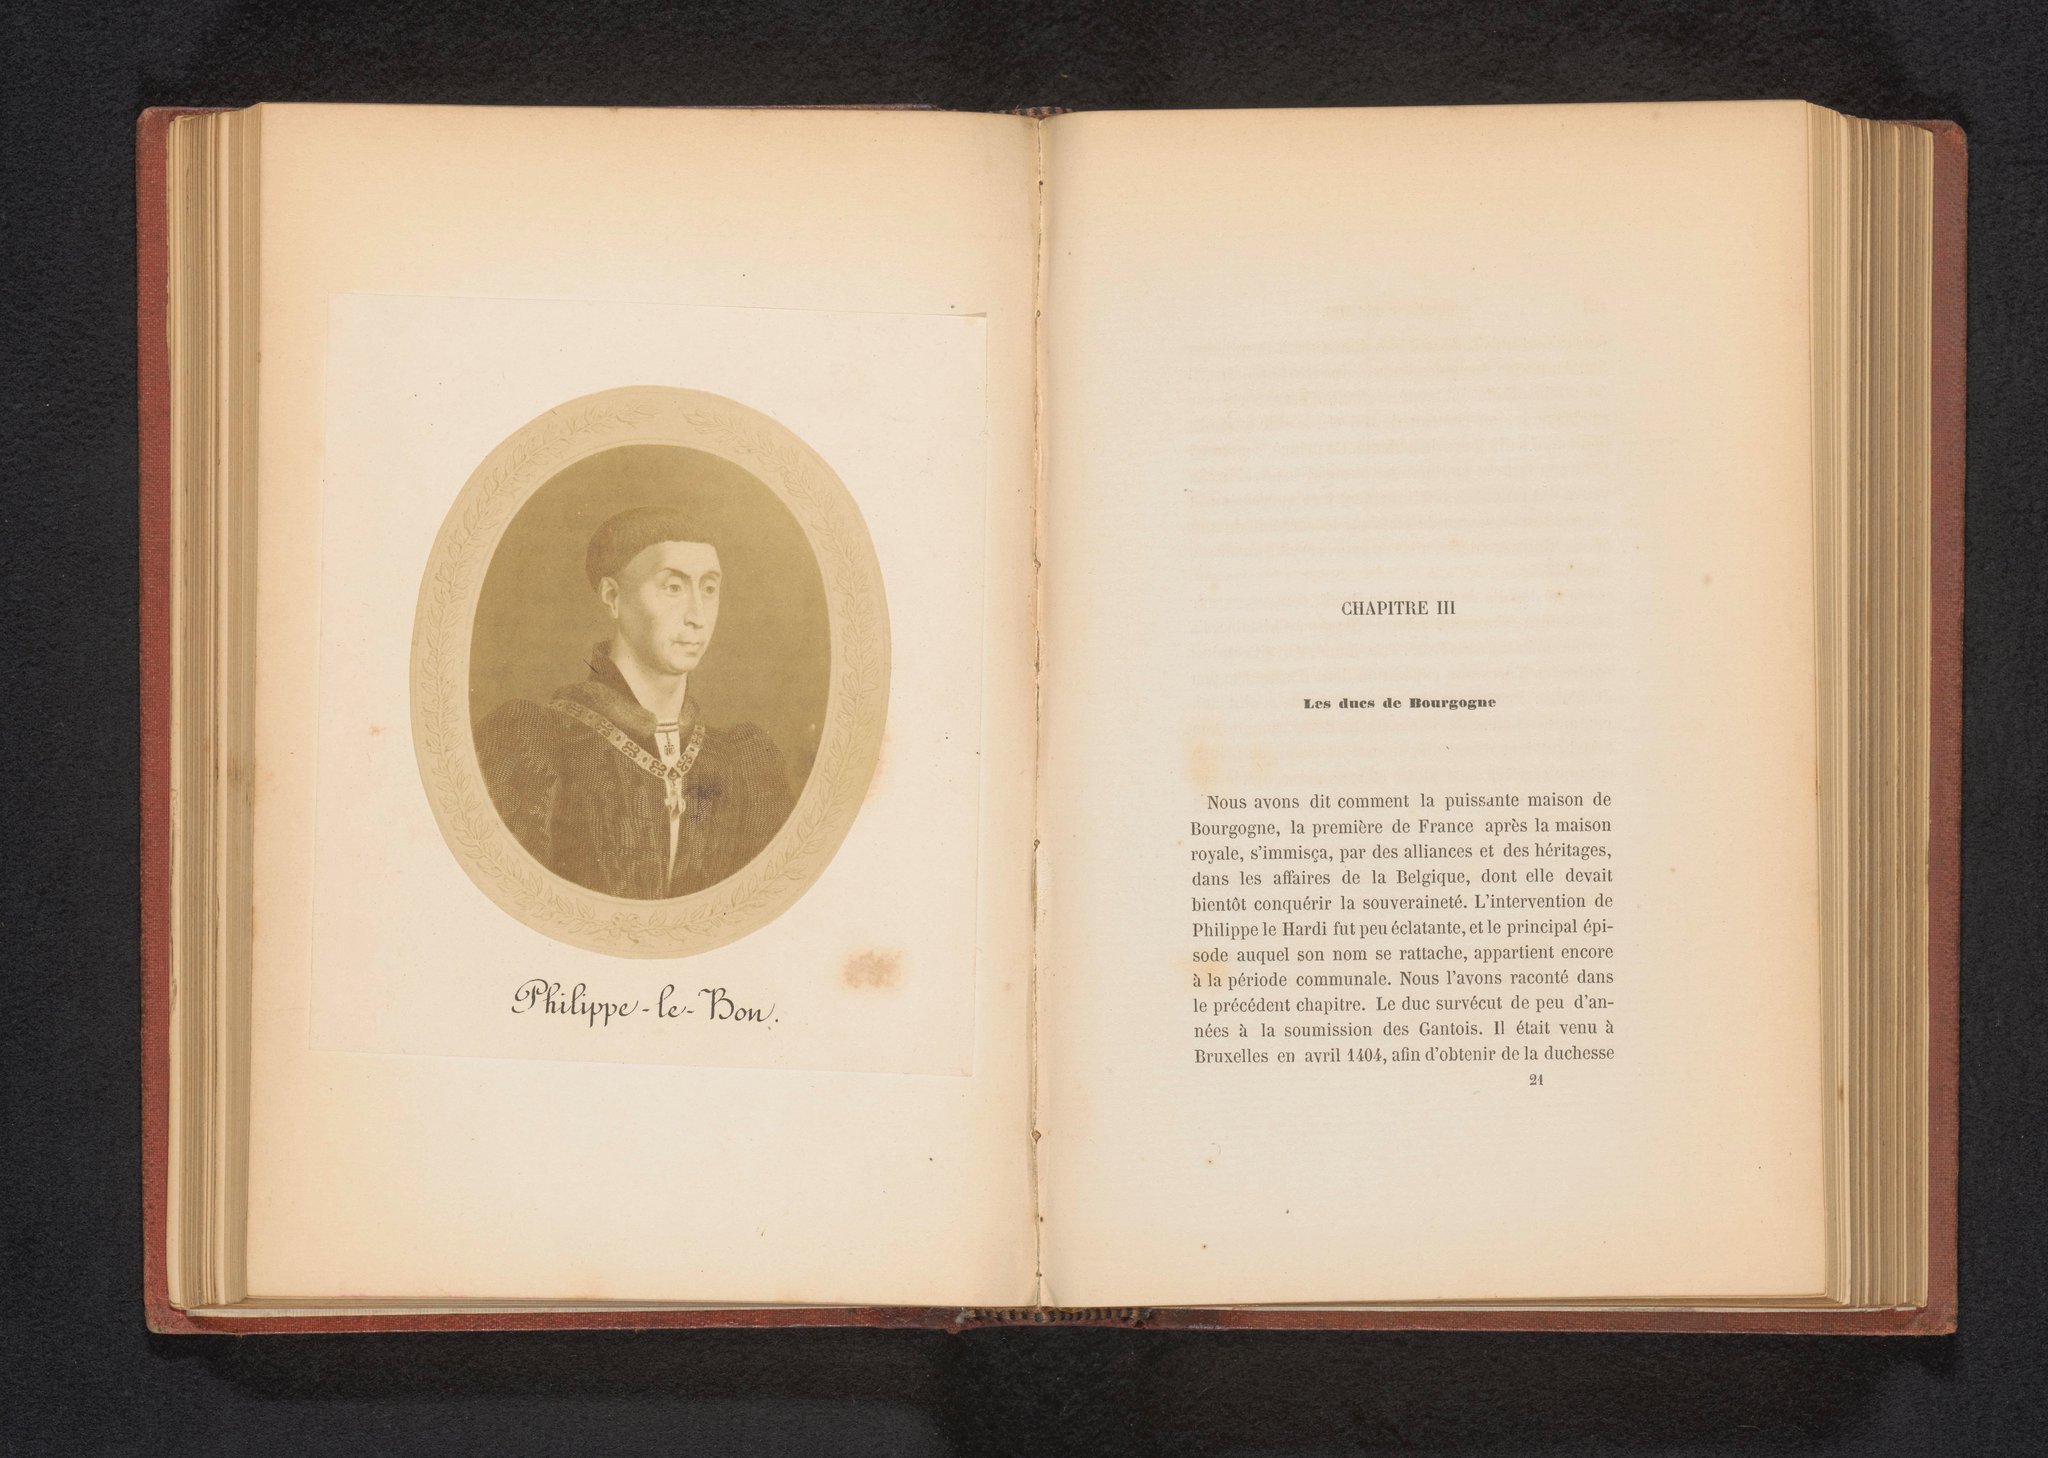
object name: reproduction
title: Philippe le Bon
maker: joseph maes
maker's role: fotograaf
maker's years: 1838-1908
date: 1855-1860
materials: photographic support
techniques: albumen print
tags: bruges, philip iii the good, historical persons